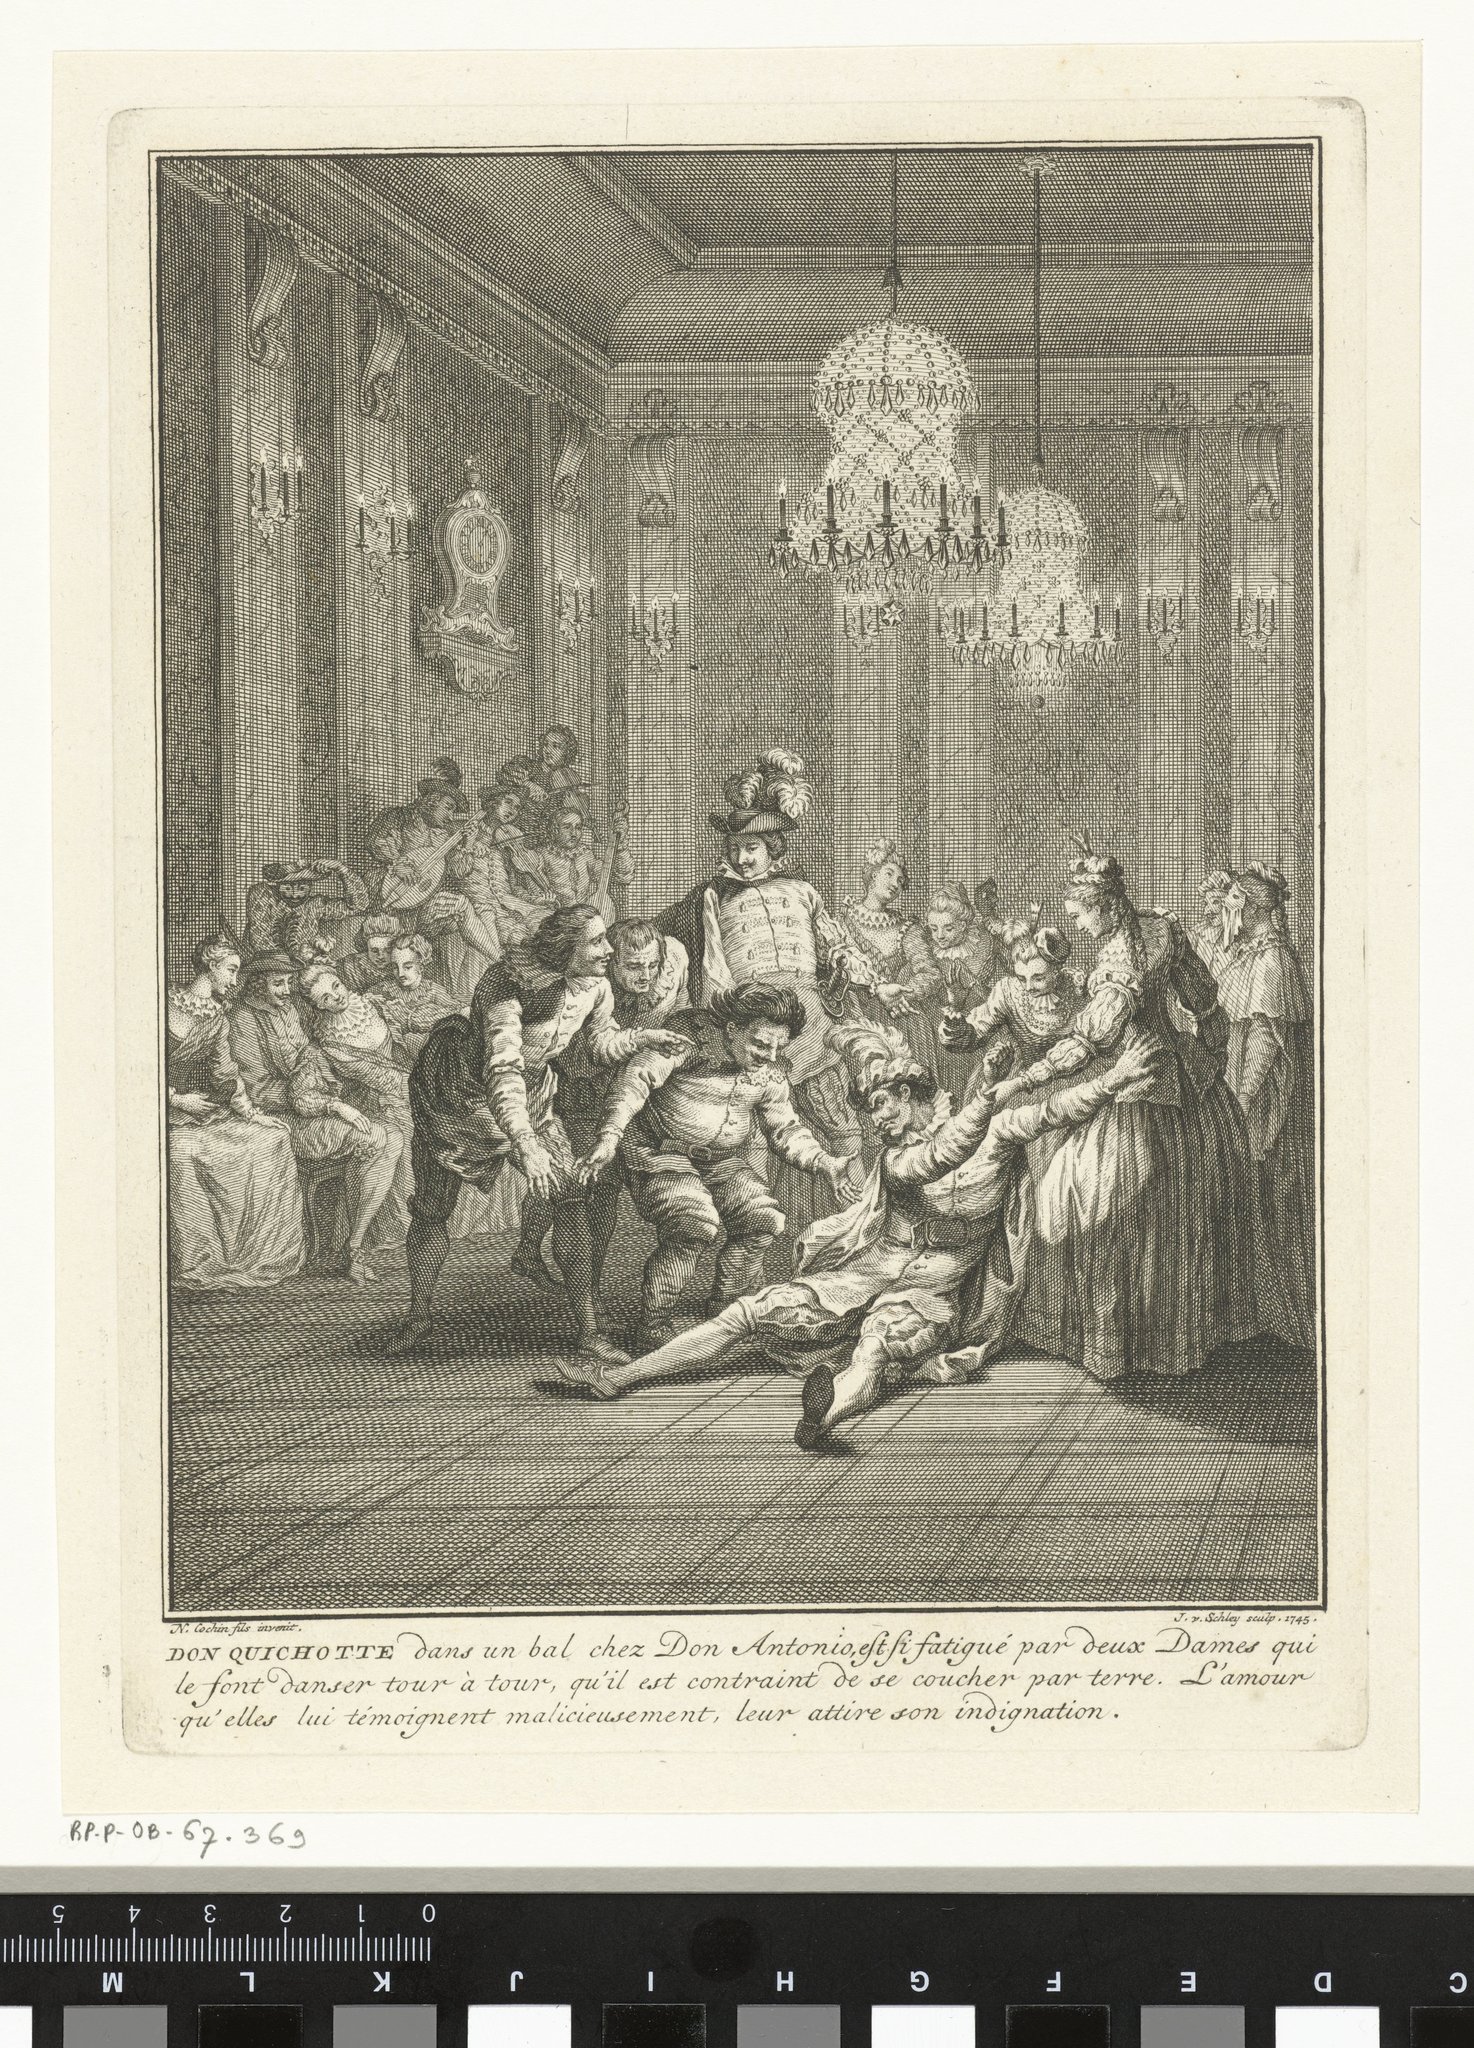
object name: print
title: Don Quichot ten val geraakt tijdens een bal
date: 1745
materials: paper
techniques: engraving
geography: amsterdam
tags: ball, formal dance, falling, don quixote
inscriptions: date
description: Tijdens een bal is Don Quichot ten val geraakt omdat hij te veel had gedanst. Sancho probeert hem met opstaan te helpen, maar Don Quichot weigert zijn hulp in eerste instantie. De twee worden omringd door sjiek uitgedoste dames en heren. Op de achtergrond speelt een kamerorkest.